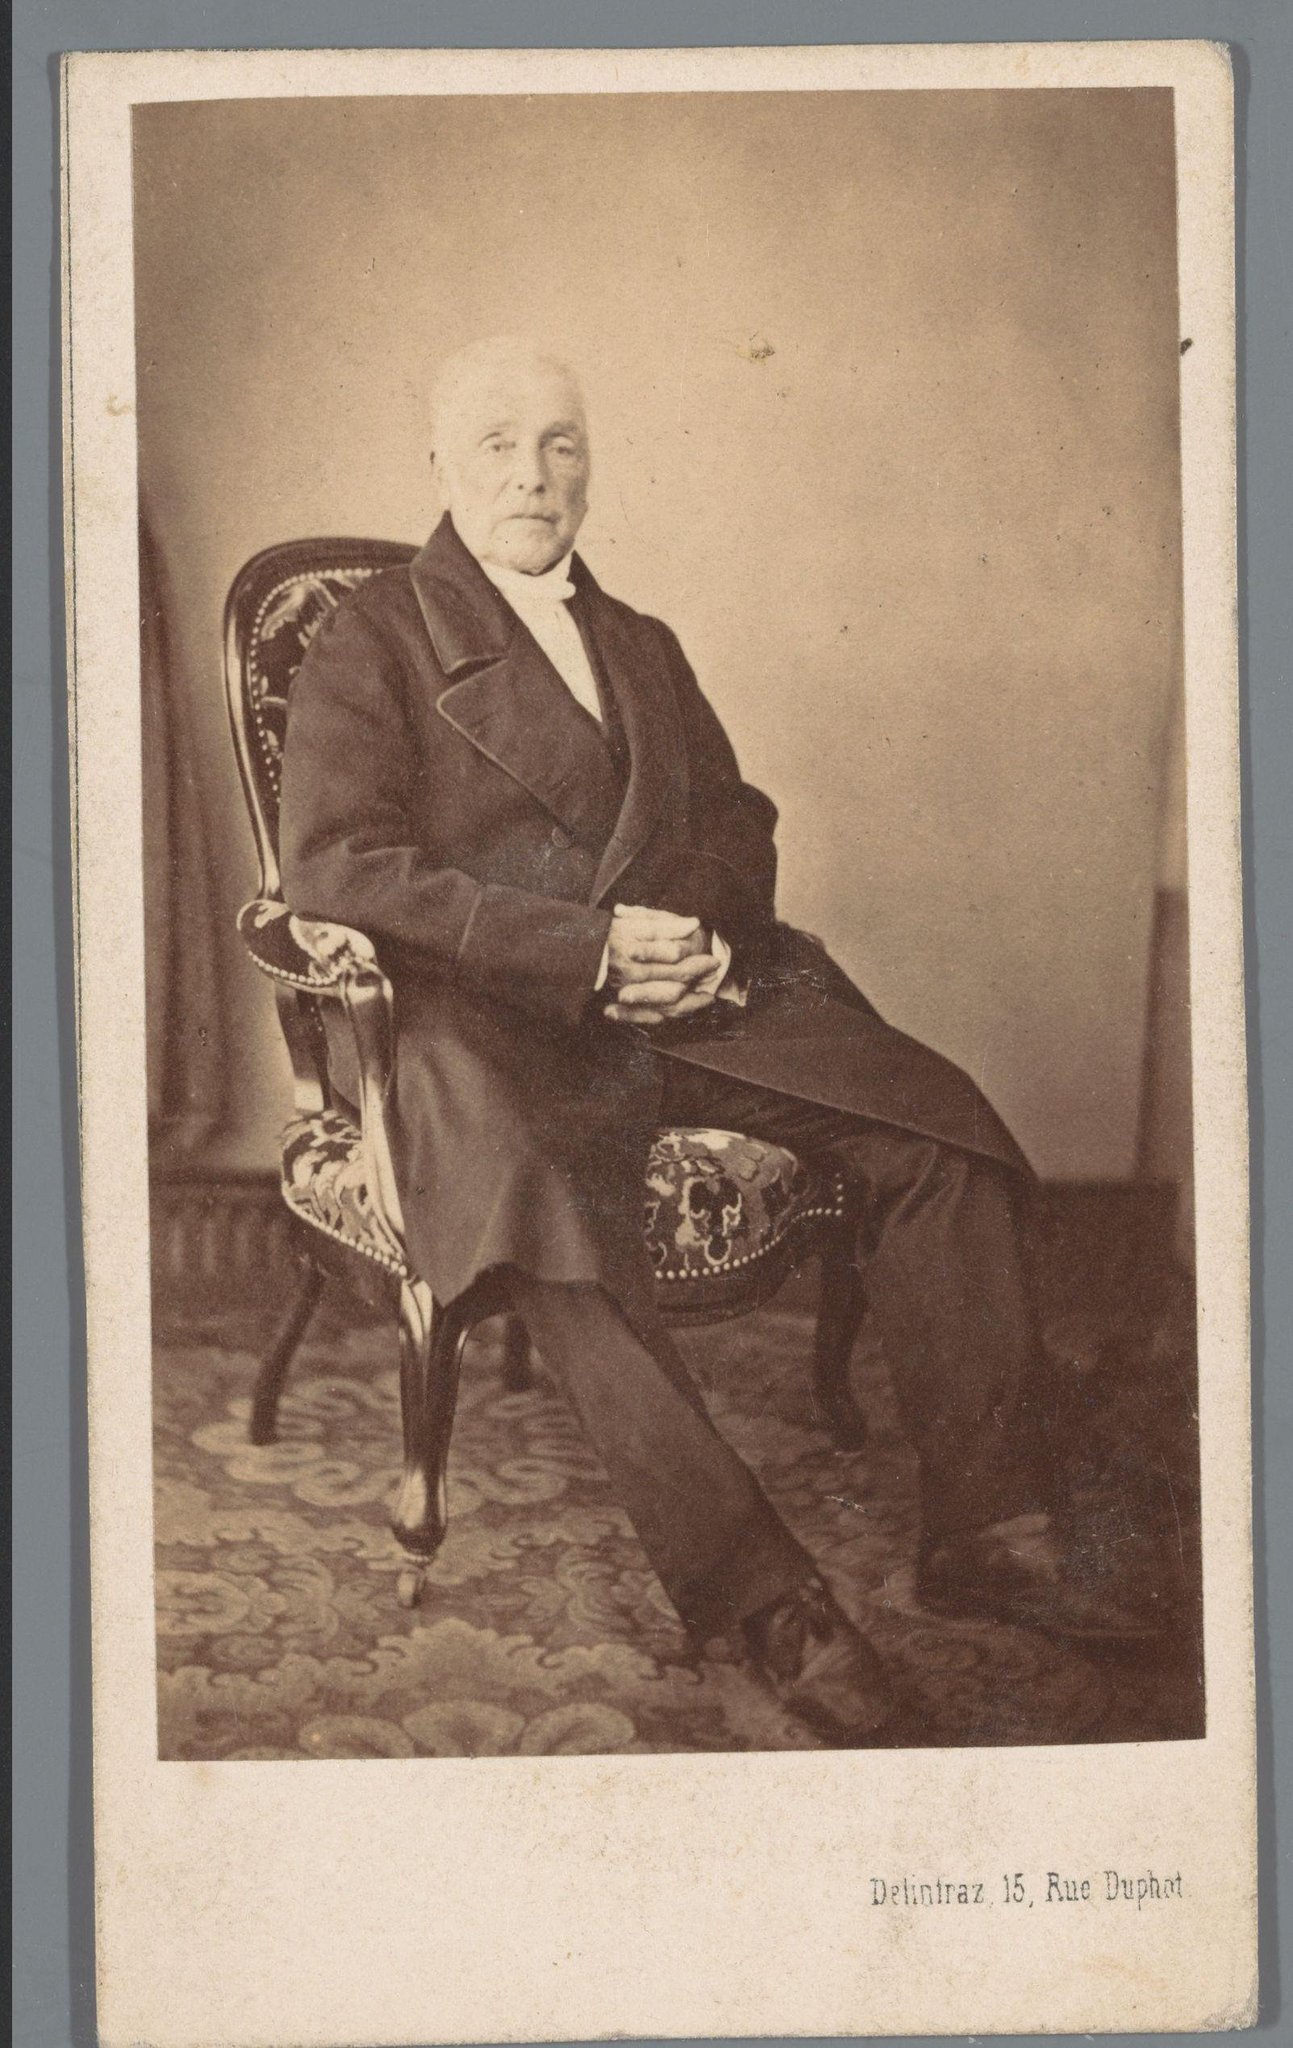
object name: carte de visite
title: Portret van een onbekende oude man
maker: françois joseph delintraz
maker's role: fotograaf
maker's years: 1827-1886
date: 1858-1868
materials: cardboard, paper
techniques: albumen print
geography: paris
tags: old man, anonymous historical person portrayed, paris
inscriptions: inscription: ‘15 Rue Duphot 15/ enface l'Eg.se de la Madeleine/ à l'Entrée du B.ar/ Delintraz/ photographe/ Spécialité de/ reproductions/ en tous genres./ Paris’, inscription: ‘Delintraz, 15, Rue Duphot’, number: ‘25’